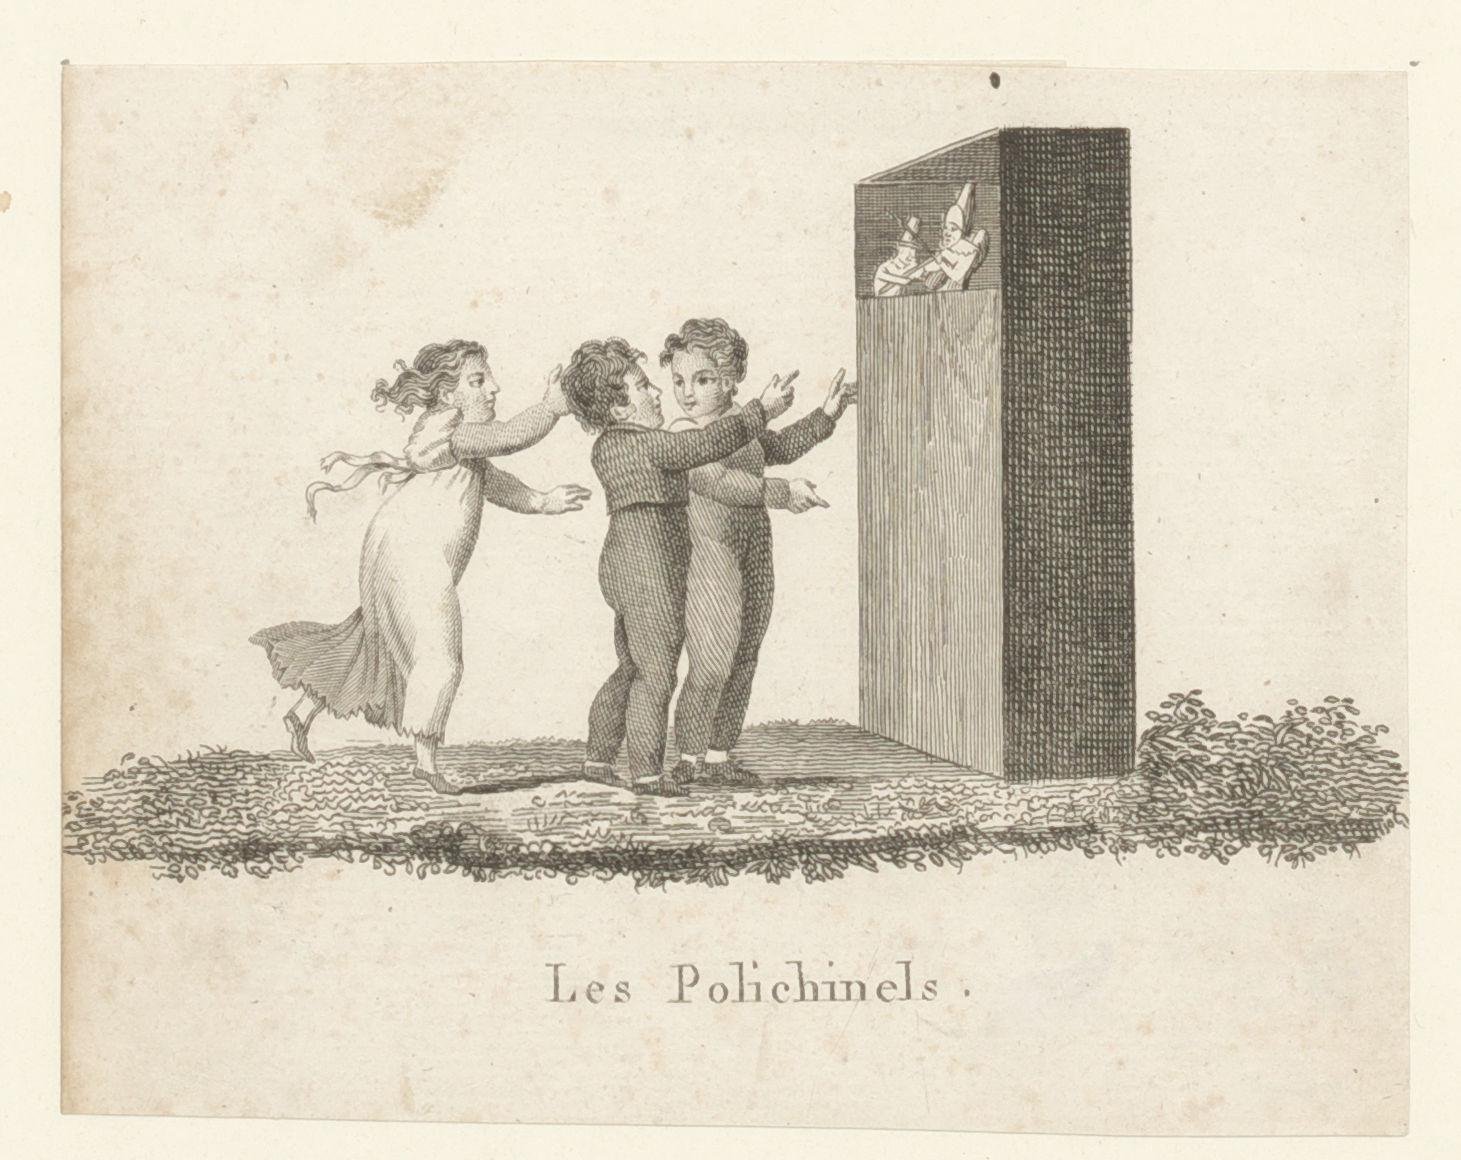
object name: print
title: Les Polichinels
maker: Anonymous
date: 1800-1899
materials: paper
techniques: etching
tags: children's games and plays, puppet and marionette show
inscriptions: stamp, collector's mark: Lugt 1641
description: Onderwerpsrubrieken binnen de Atlas Zeden en Gewoonten: Zeden en Gewoonten in Engeren Zin, Des menschen beging, midden en einde, Kinderleven – Kinderspel en Kinderprenten.